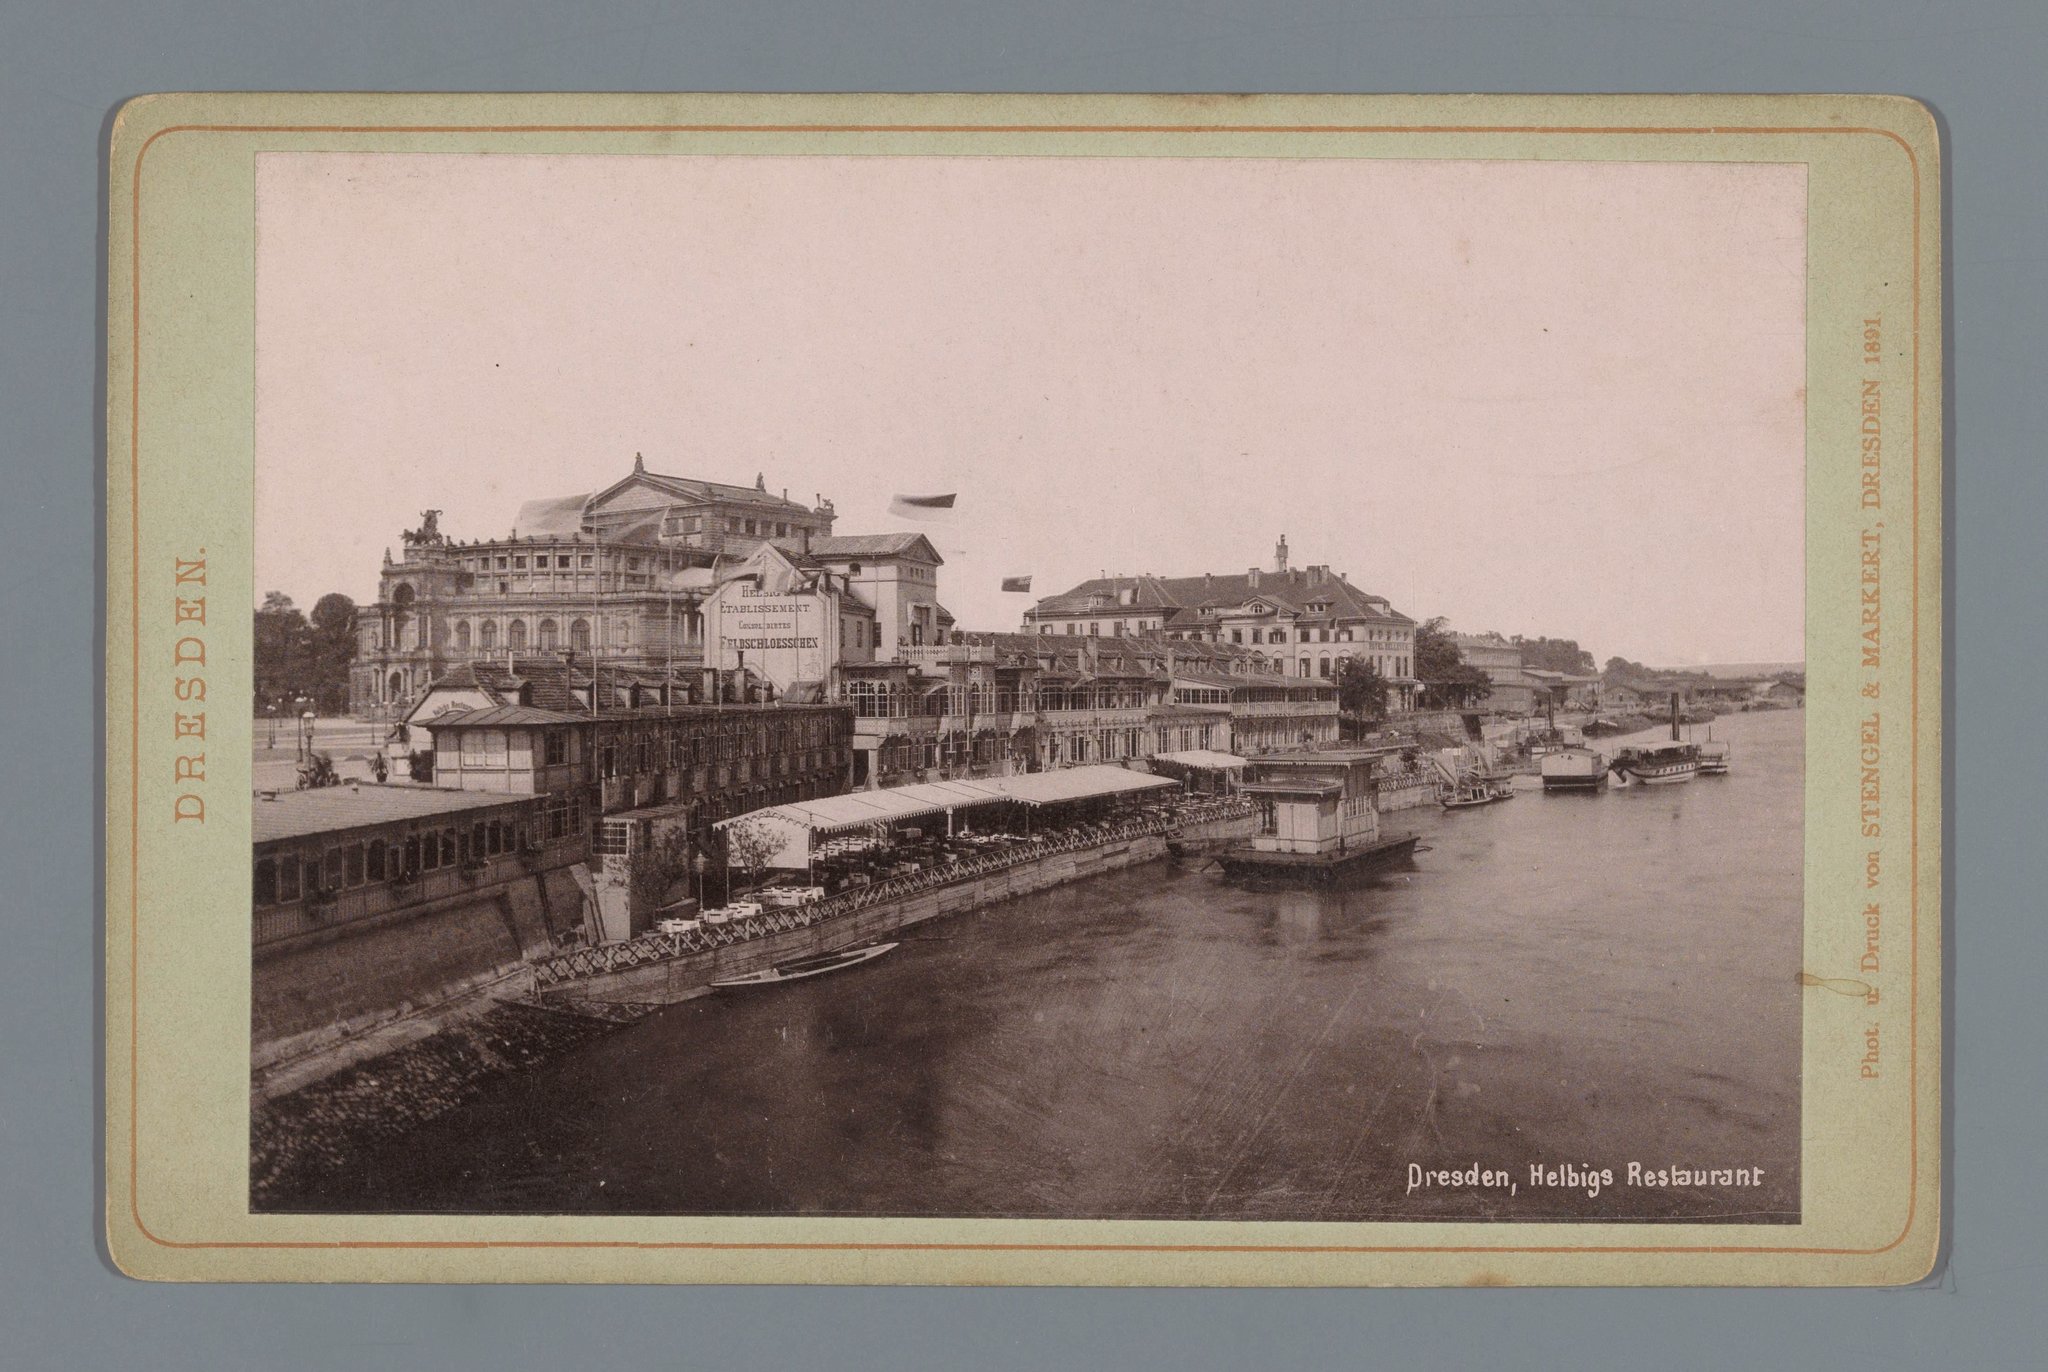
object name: photomechanical print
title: Helbigs Restaurant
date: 1891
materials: cardboard, paper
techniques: photograph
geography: dresden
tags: city-view, and landscape with man-made constructions, restaurant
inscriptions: date